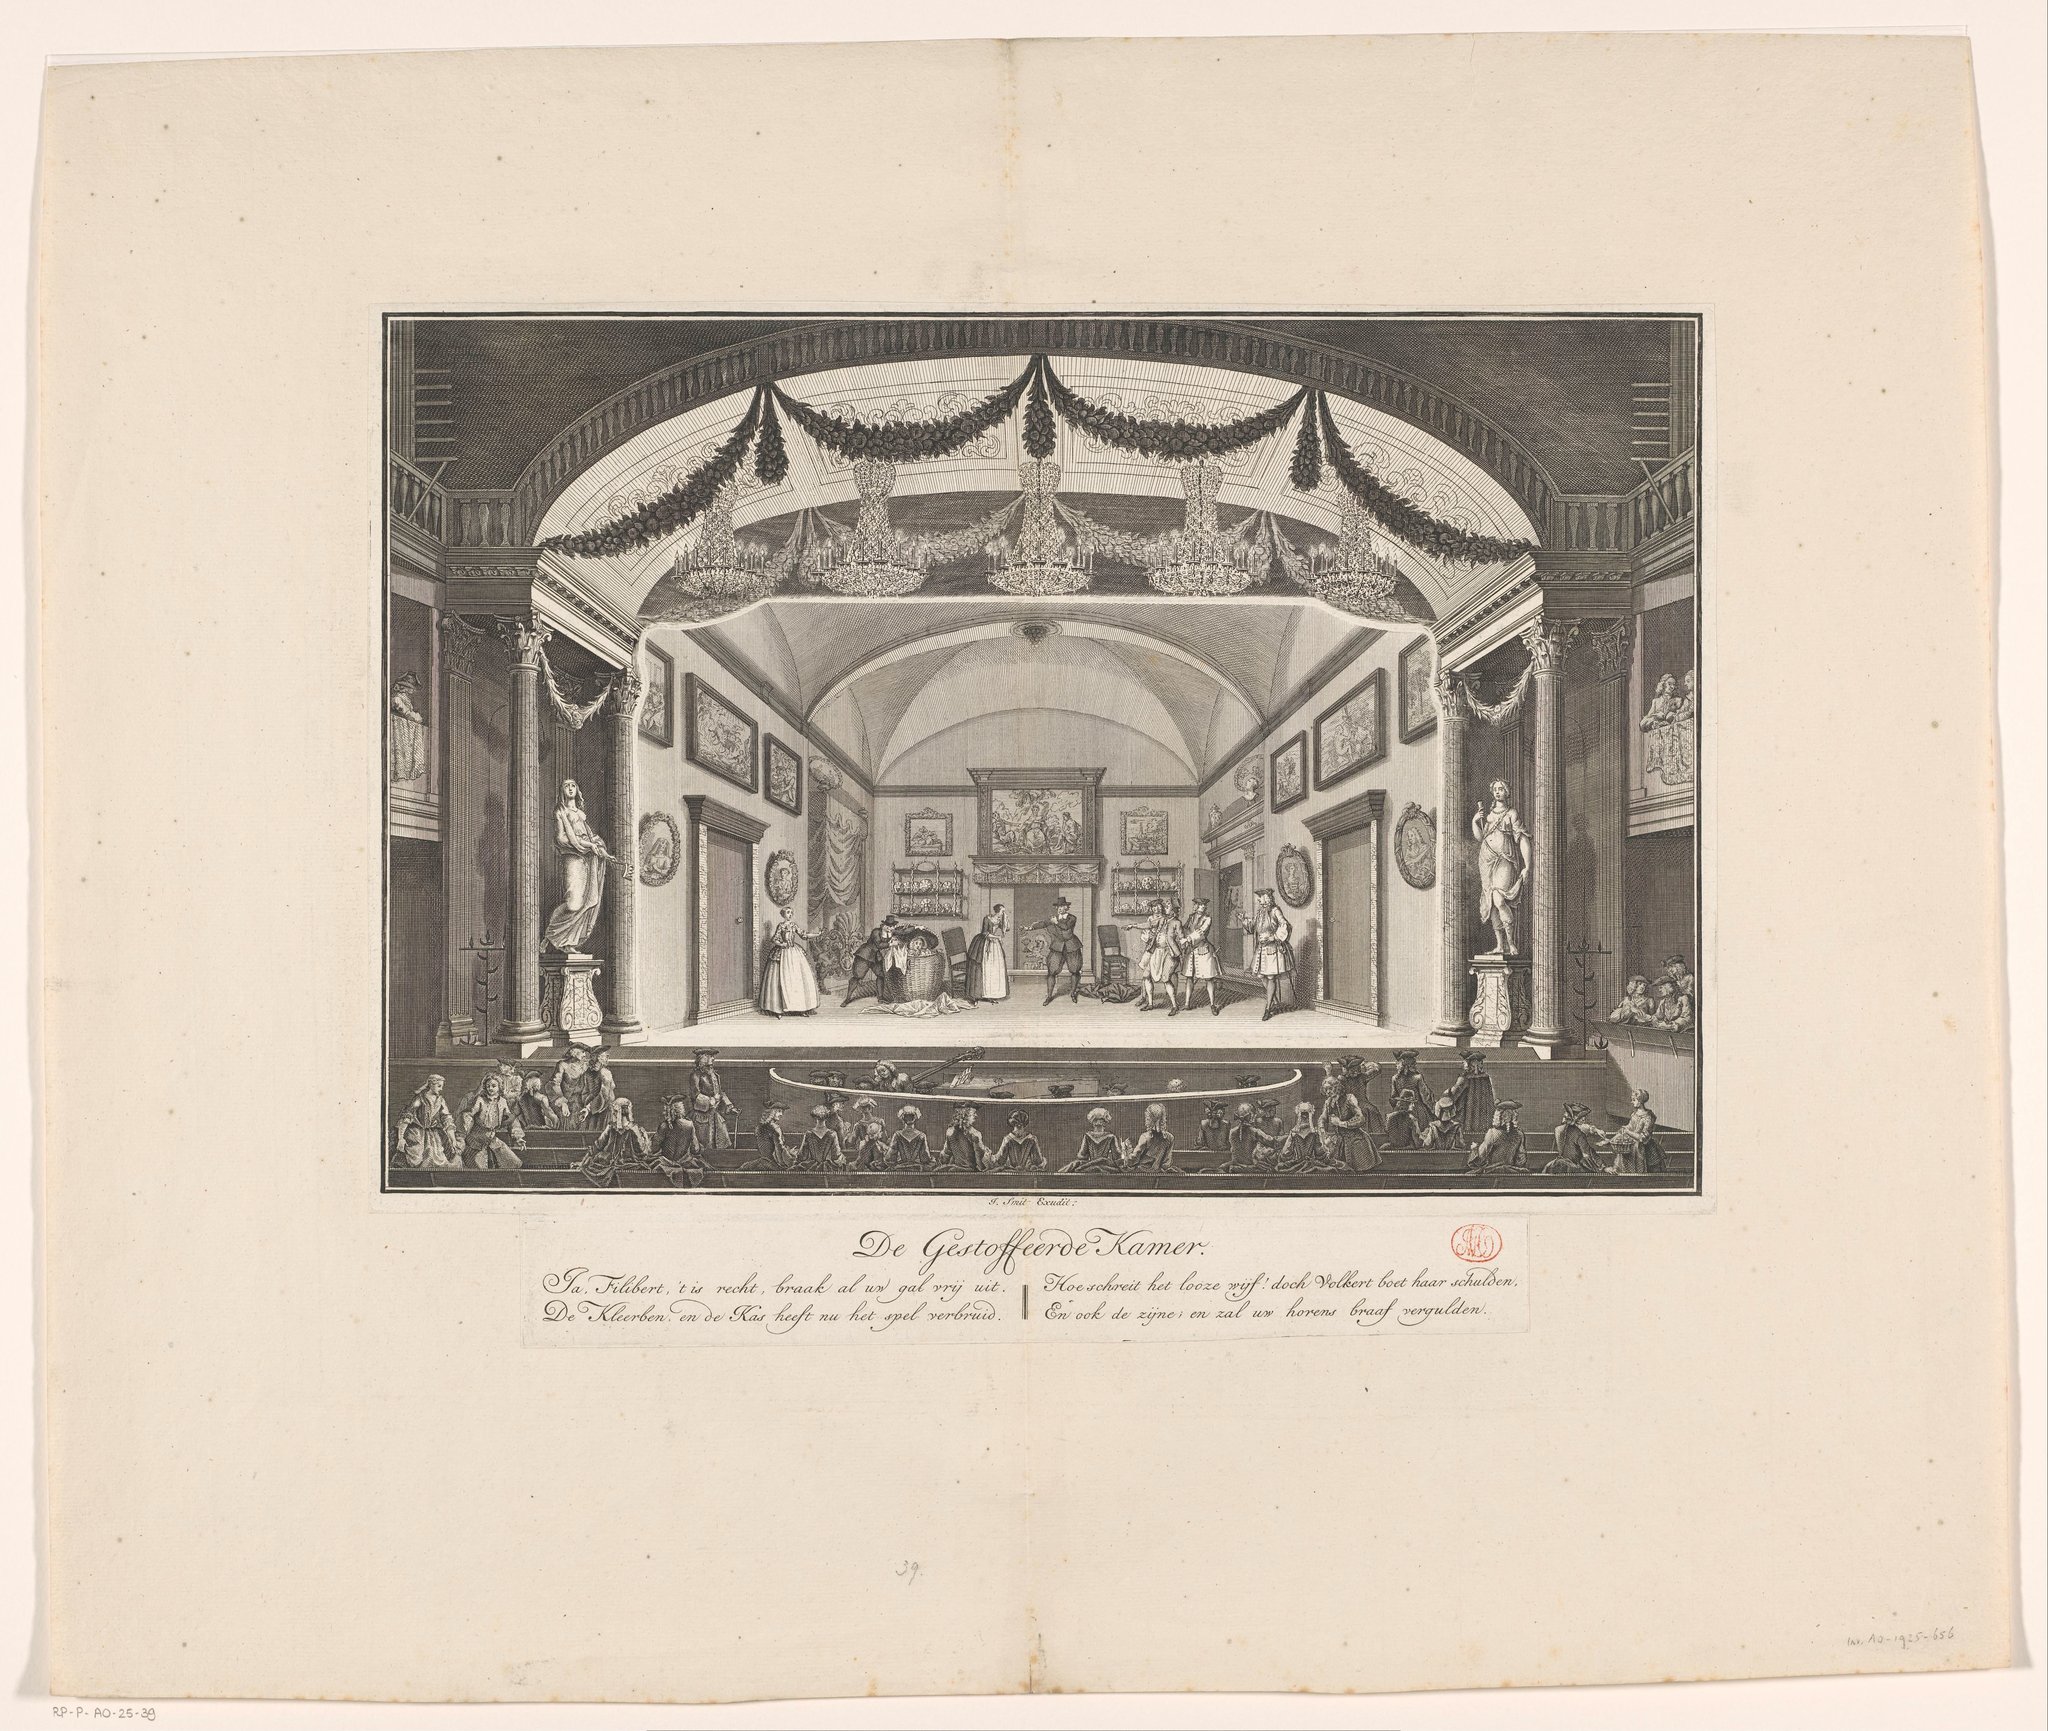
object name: print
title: Schouwburg met toneeldecor: De Gestoffeerde Kamer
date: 1736-1738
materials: paper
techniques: engraving, etching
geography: amsterdam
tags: theatre, theatrical performance, stage design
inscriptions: collector's mark: Lugt 195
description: Toneelvoorstelling in de Amsterdamse Schouwburg op de Keizersgracht met het coulissendecor De Gestoffeerde Kamer met scène uit: De ontdekte schyndeugd. Het decor gedrukt van een aparte plaat binnen een passe-partout met de zaal, zijloges, orkestbak en de façade van het toneel met zuilen, guirlandes en kroonluchters. De titel en een vierregelig vers ook gedrukt van een aparte plaat. Onderdeel van een serie van 12 toneeldecors.